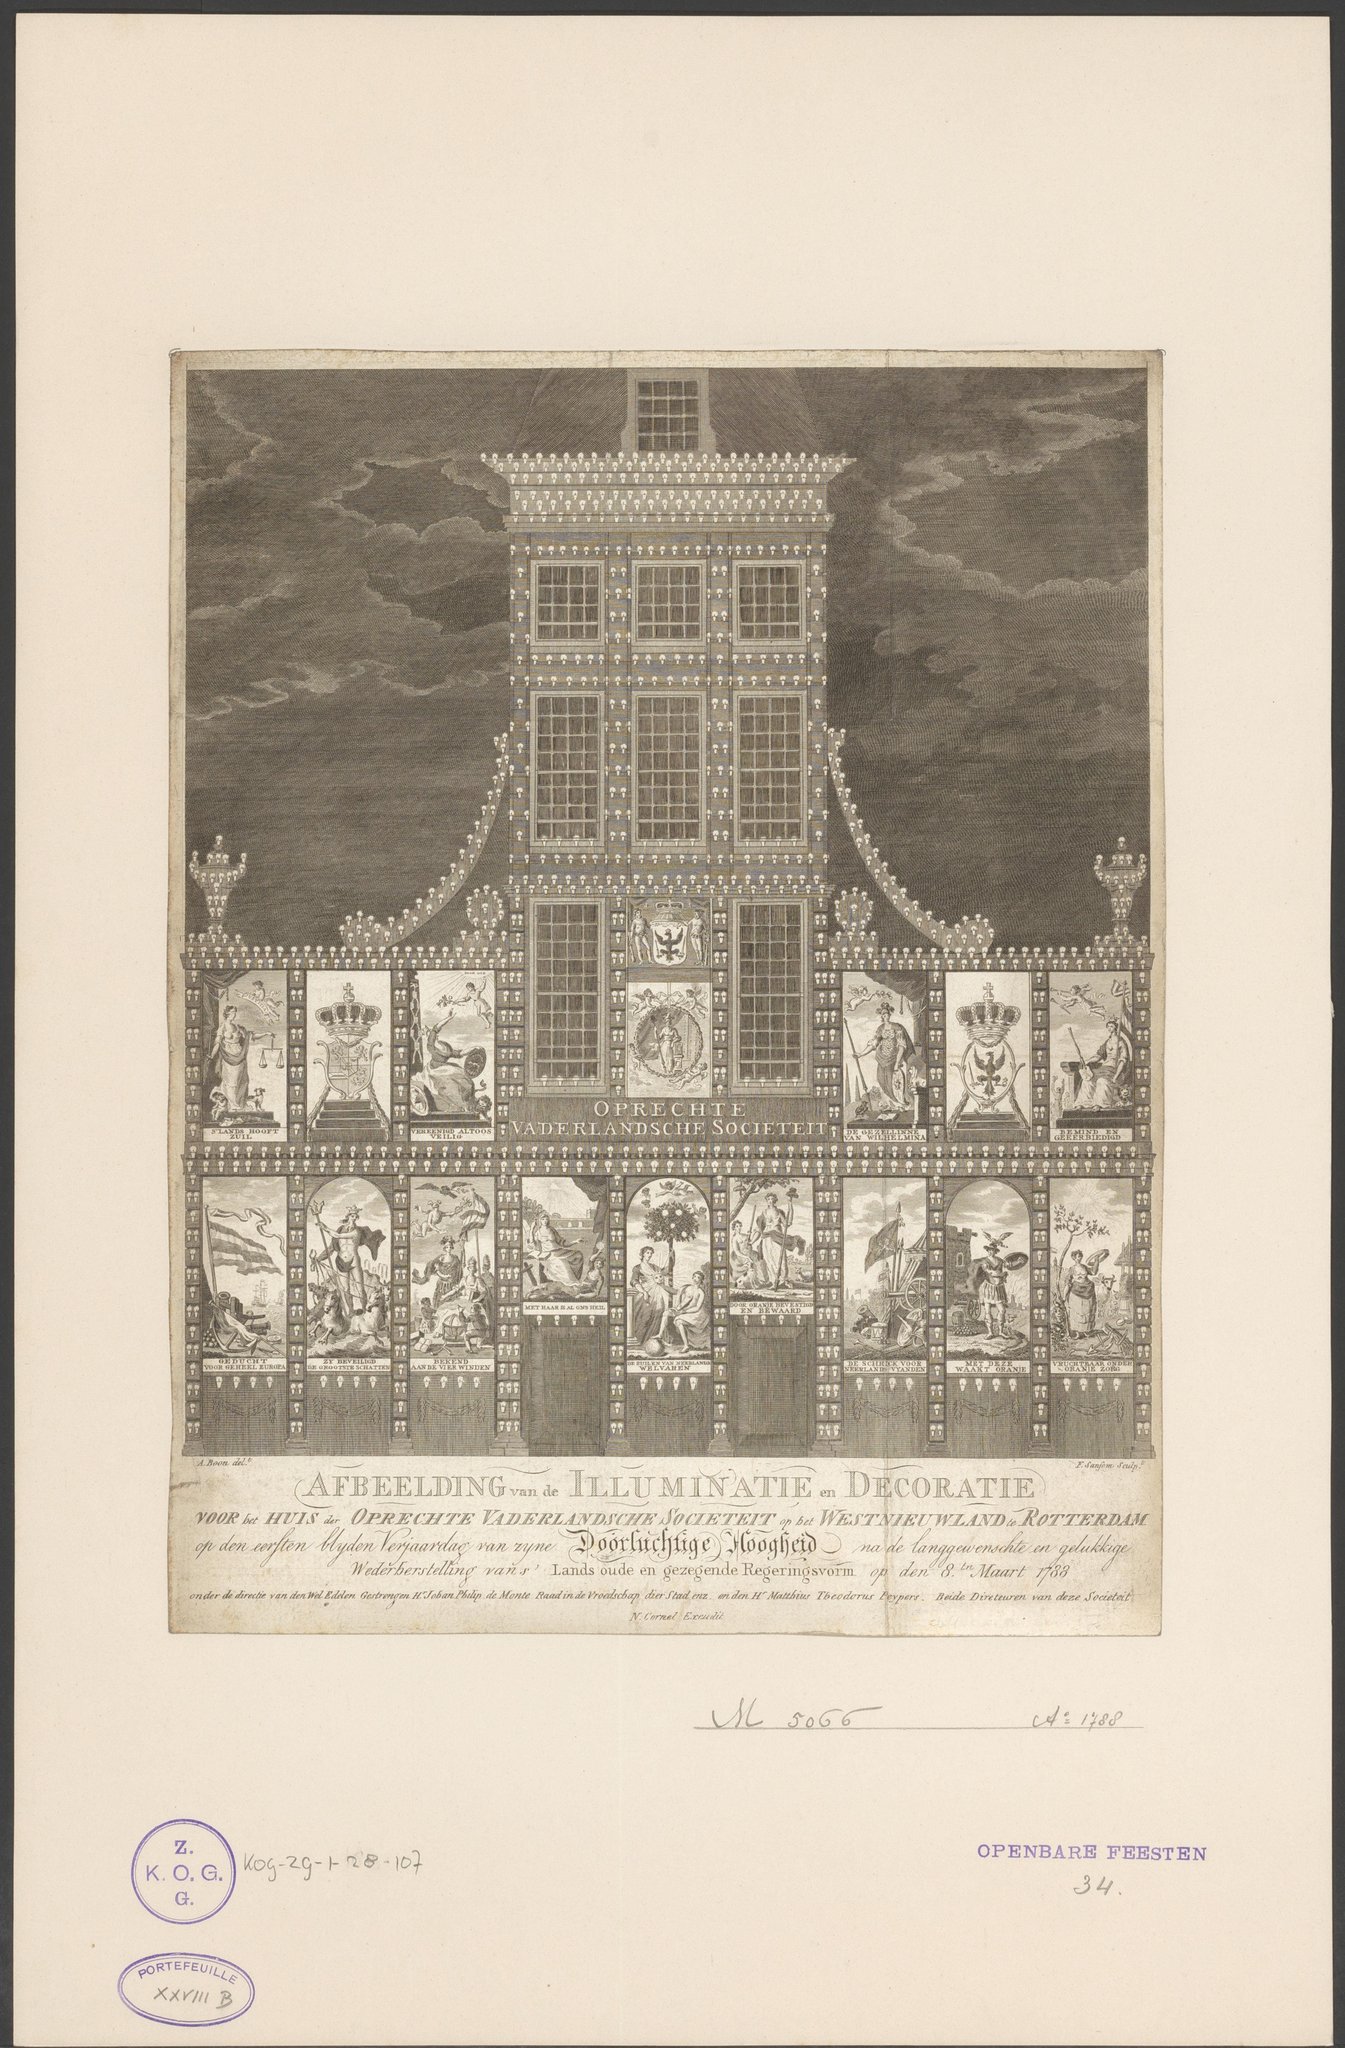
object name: print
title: Afbeelding van de Illuminatie en Decoratie voor het Huis der Oprechte Vaderlandsche Societeit op het Westnieuwland te Rotterdam (...) 8 Maart 1788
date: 1788-1790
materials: paper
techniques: engraving, etching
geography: rotterdam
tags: bonfire, fire-works (+ festive decoration ~ festive activities)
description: Illuminatie van de gevel van het pand van de Oprechte Vaderlandsche Sociëteit op het Westnieuwland te Rotterdam, ter gelegenheid van de veertigste verjaardag van prins Willem V op 8 maart 1788 en het herstel van de oude constitutie. De gevel versierd met lichtjes en zestien chassinetten met allegorische voorstellingen (vóór de twee die pas later op 7 augustus zijn geplaatst). Onderwerpsrubrieken binnen de Atlas Zeden en Gewoonten: Zeden en Gewoonten in Engeren Zin. Volksleven. Openbare feesten. Vorstelijke intochten, (Illuminaties, vuurwerken en dergelijke, openbare feesten).